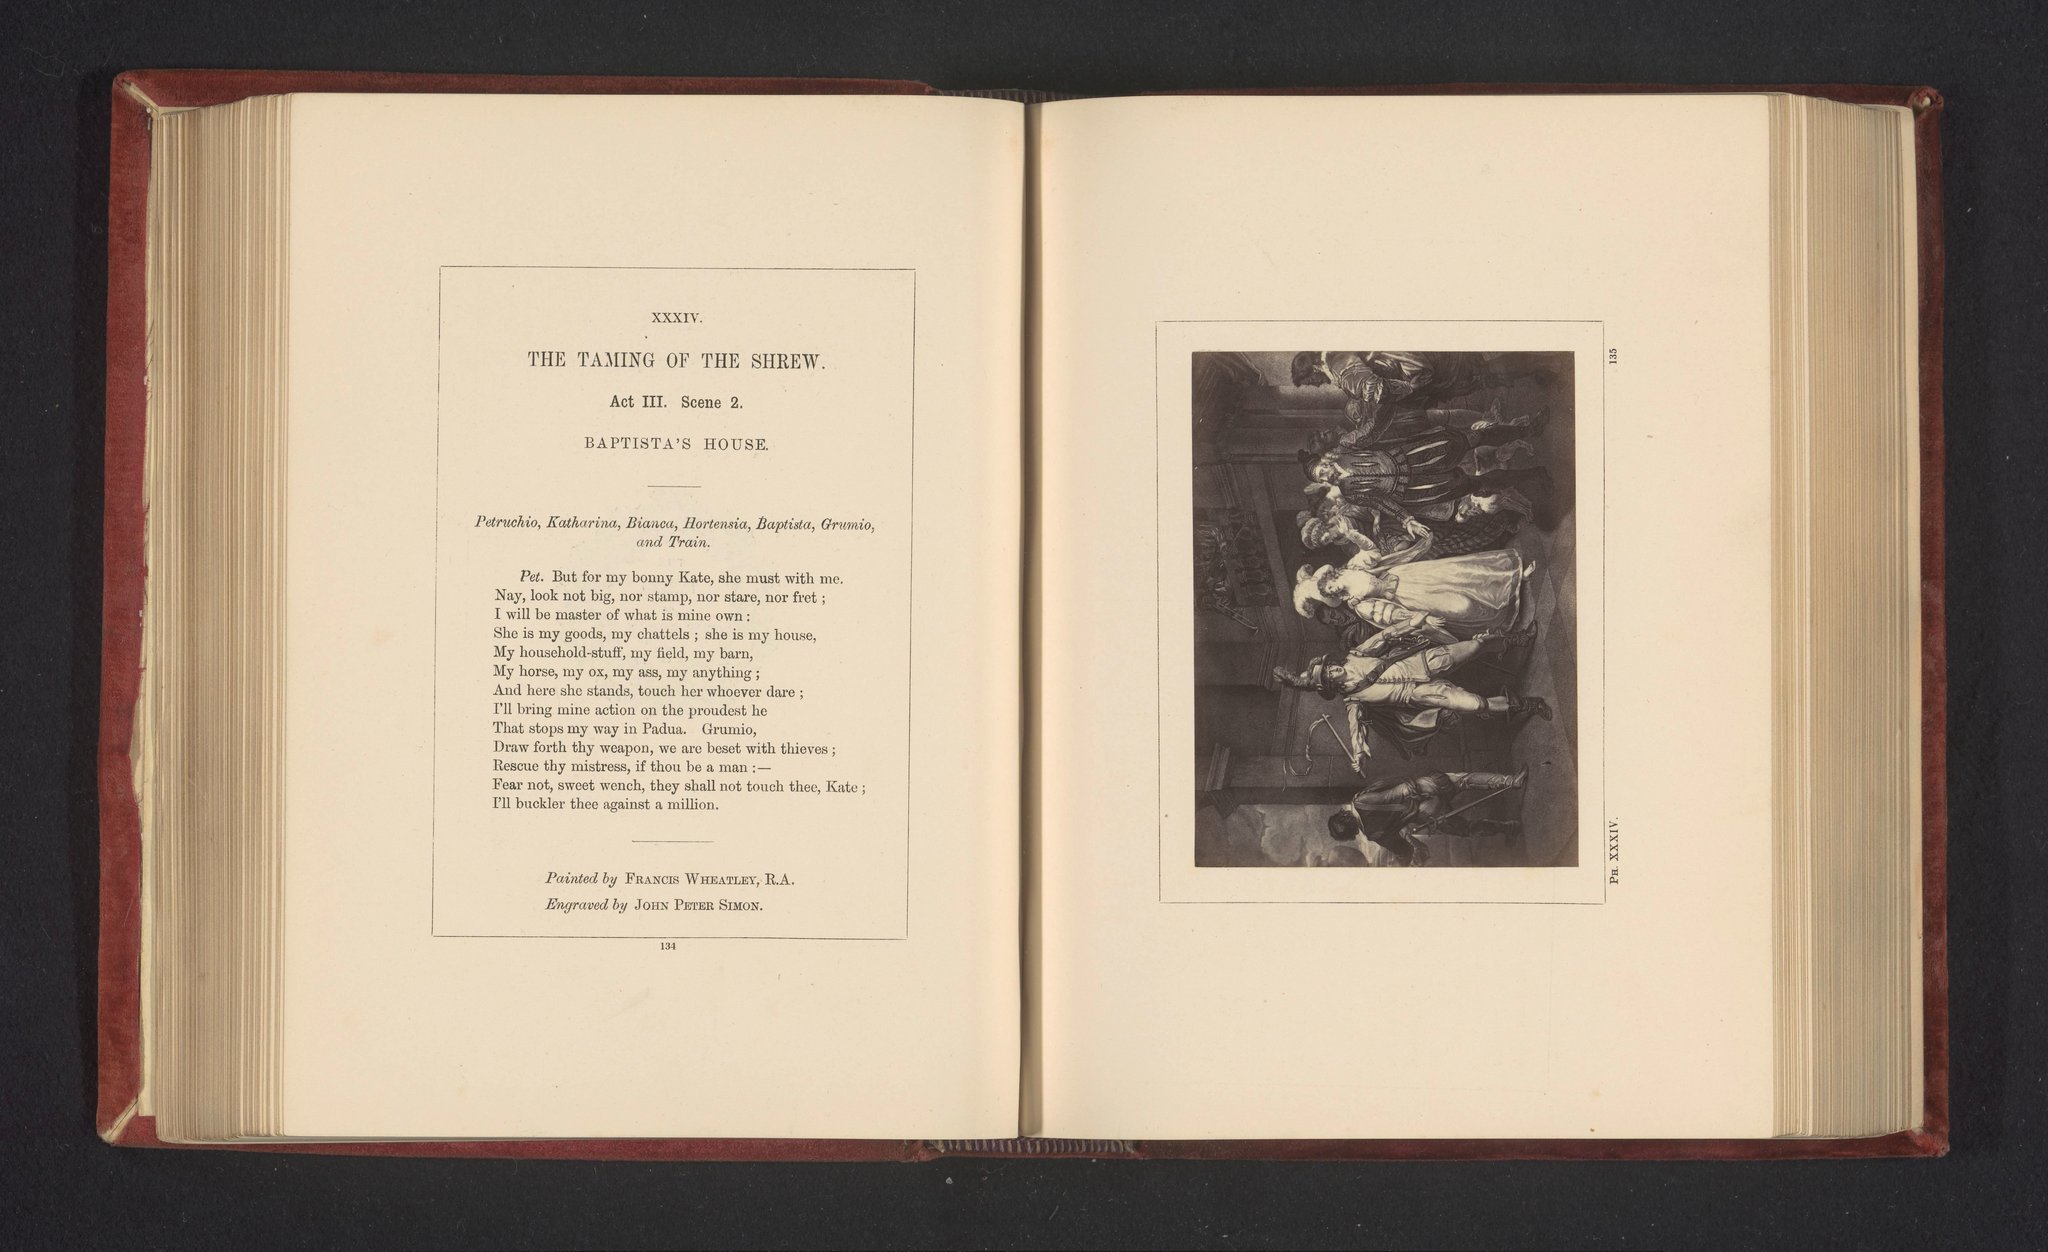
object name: photograph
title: Fotoreproductie van een prent naar een schilderij door Francis Wheatley, voorstellend een scene uit Het temmen van de feeks door William Shakespeare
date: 1854-1864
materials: photographic support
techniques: albumen print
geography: london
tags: specific works of literature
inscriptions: number: ‘Ph. XXXIV. 135’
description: Te zien is akte III, scene 2 met Bianca, Katherina, Petruchio en anderen.